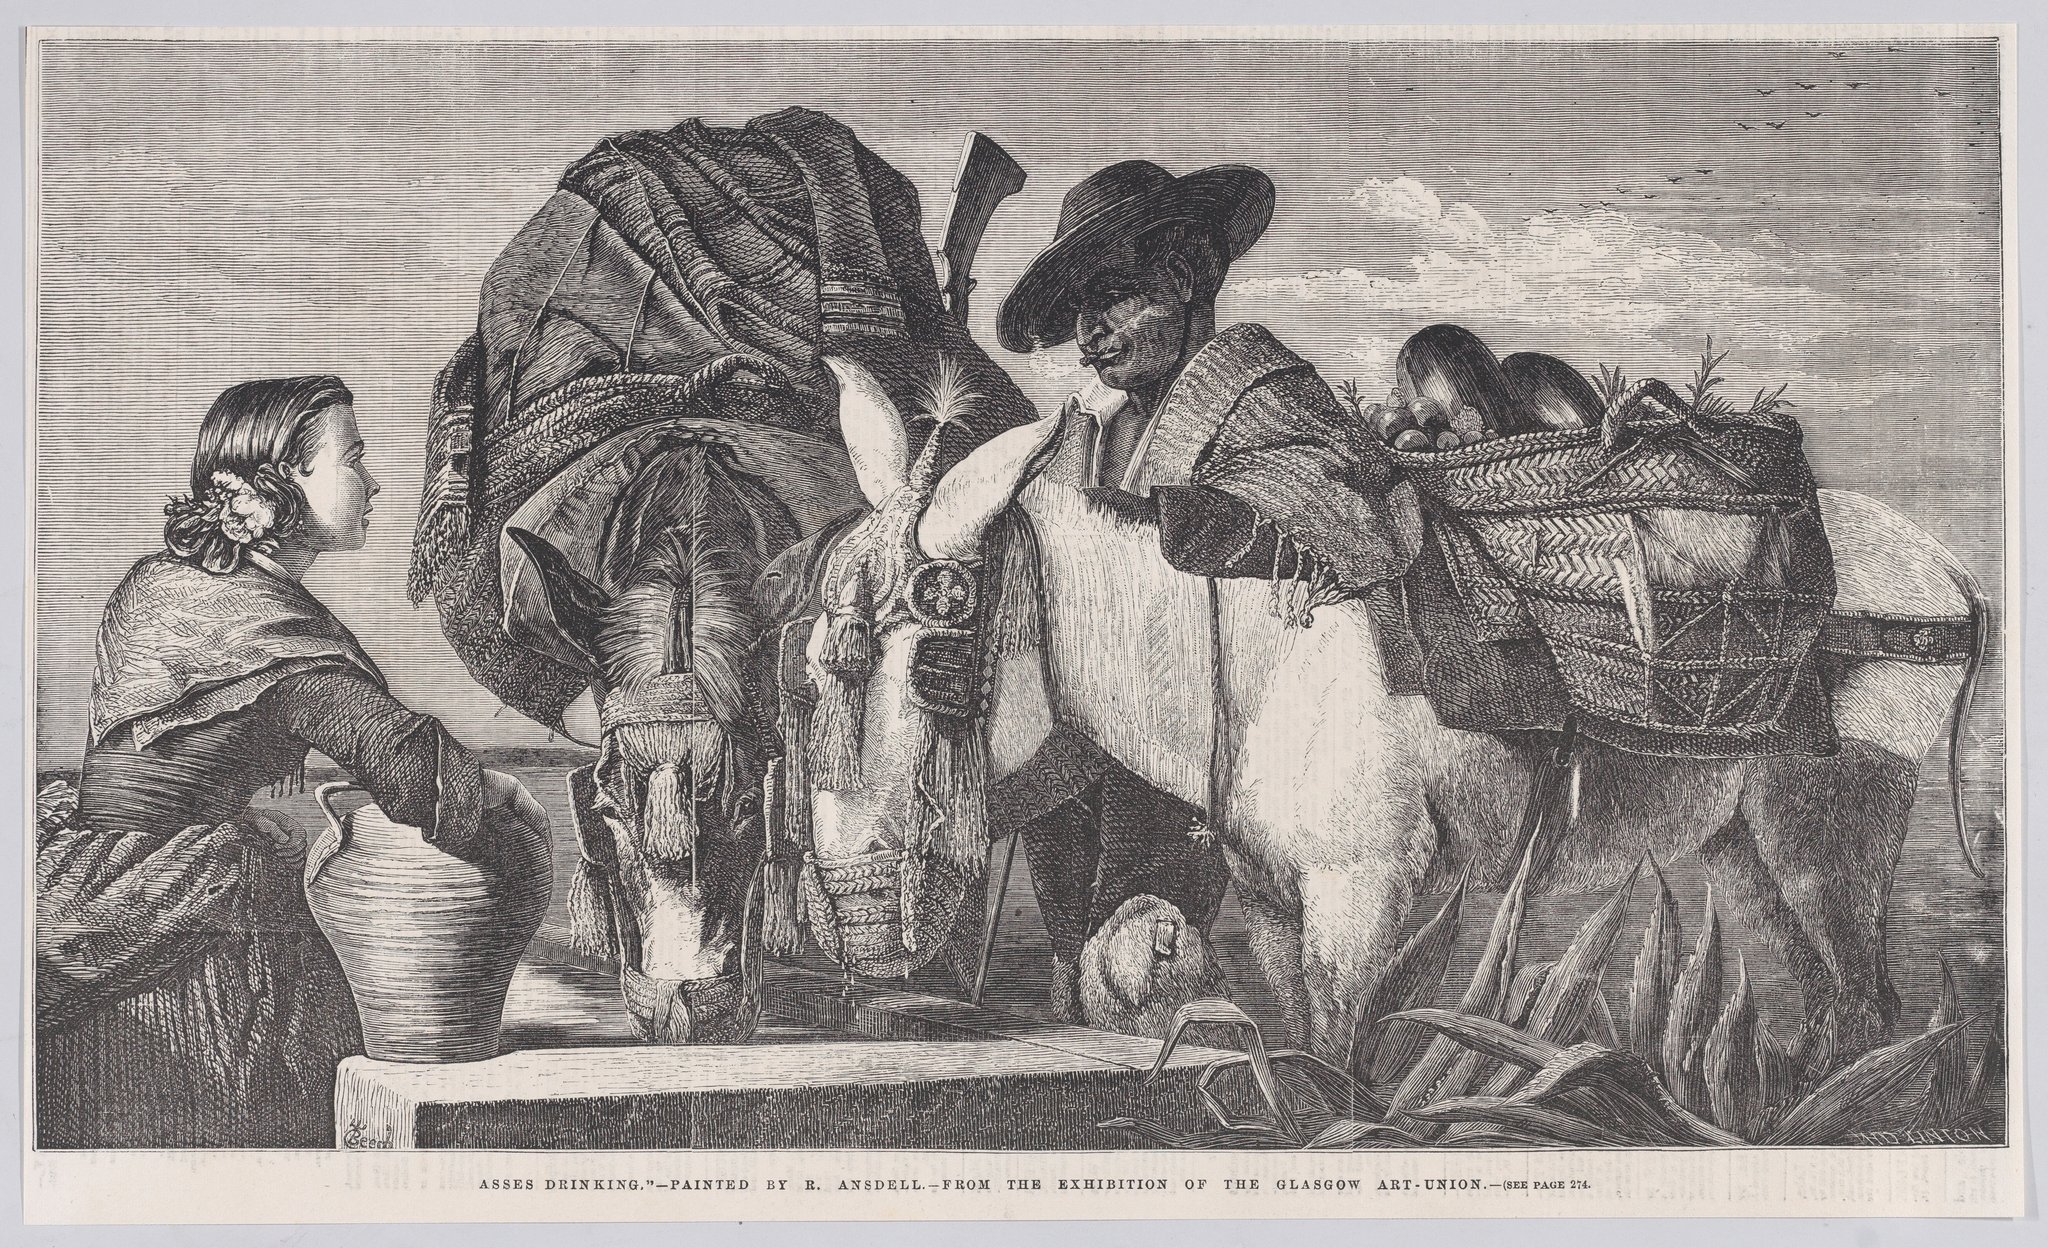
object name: print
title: Asses Drinking, from "Illustrated London News"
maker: henry linton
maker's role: engraver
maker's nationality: british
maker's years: 1815-1899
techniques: engraving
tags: men,women,donkeys